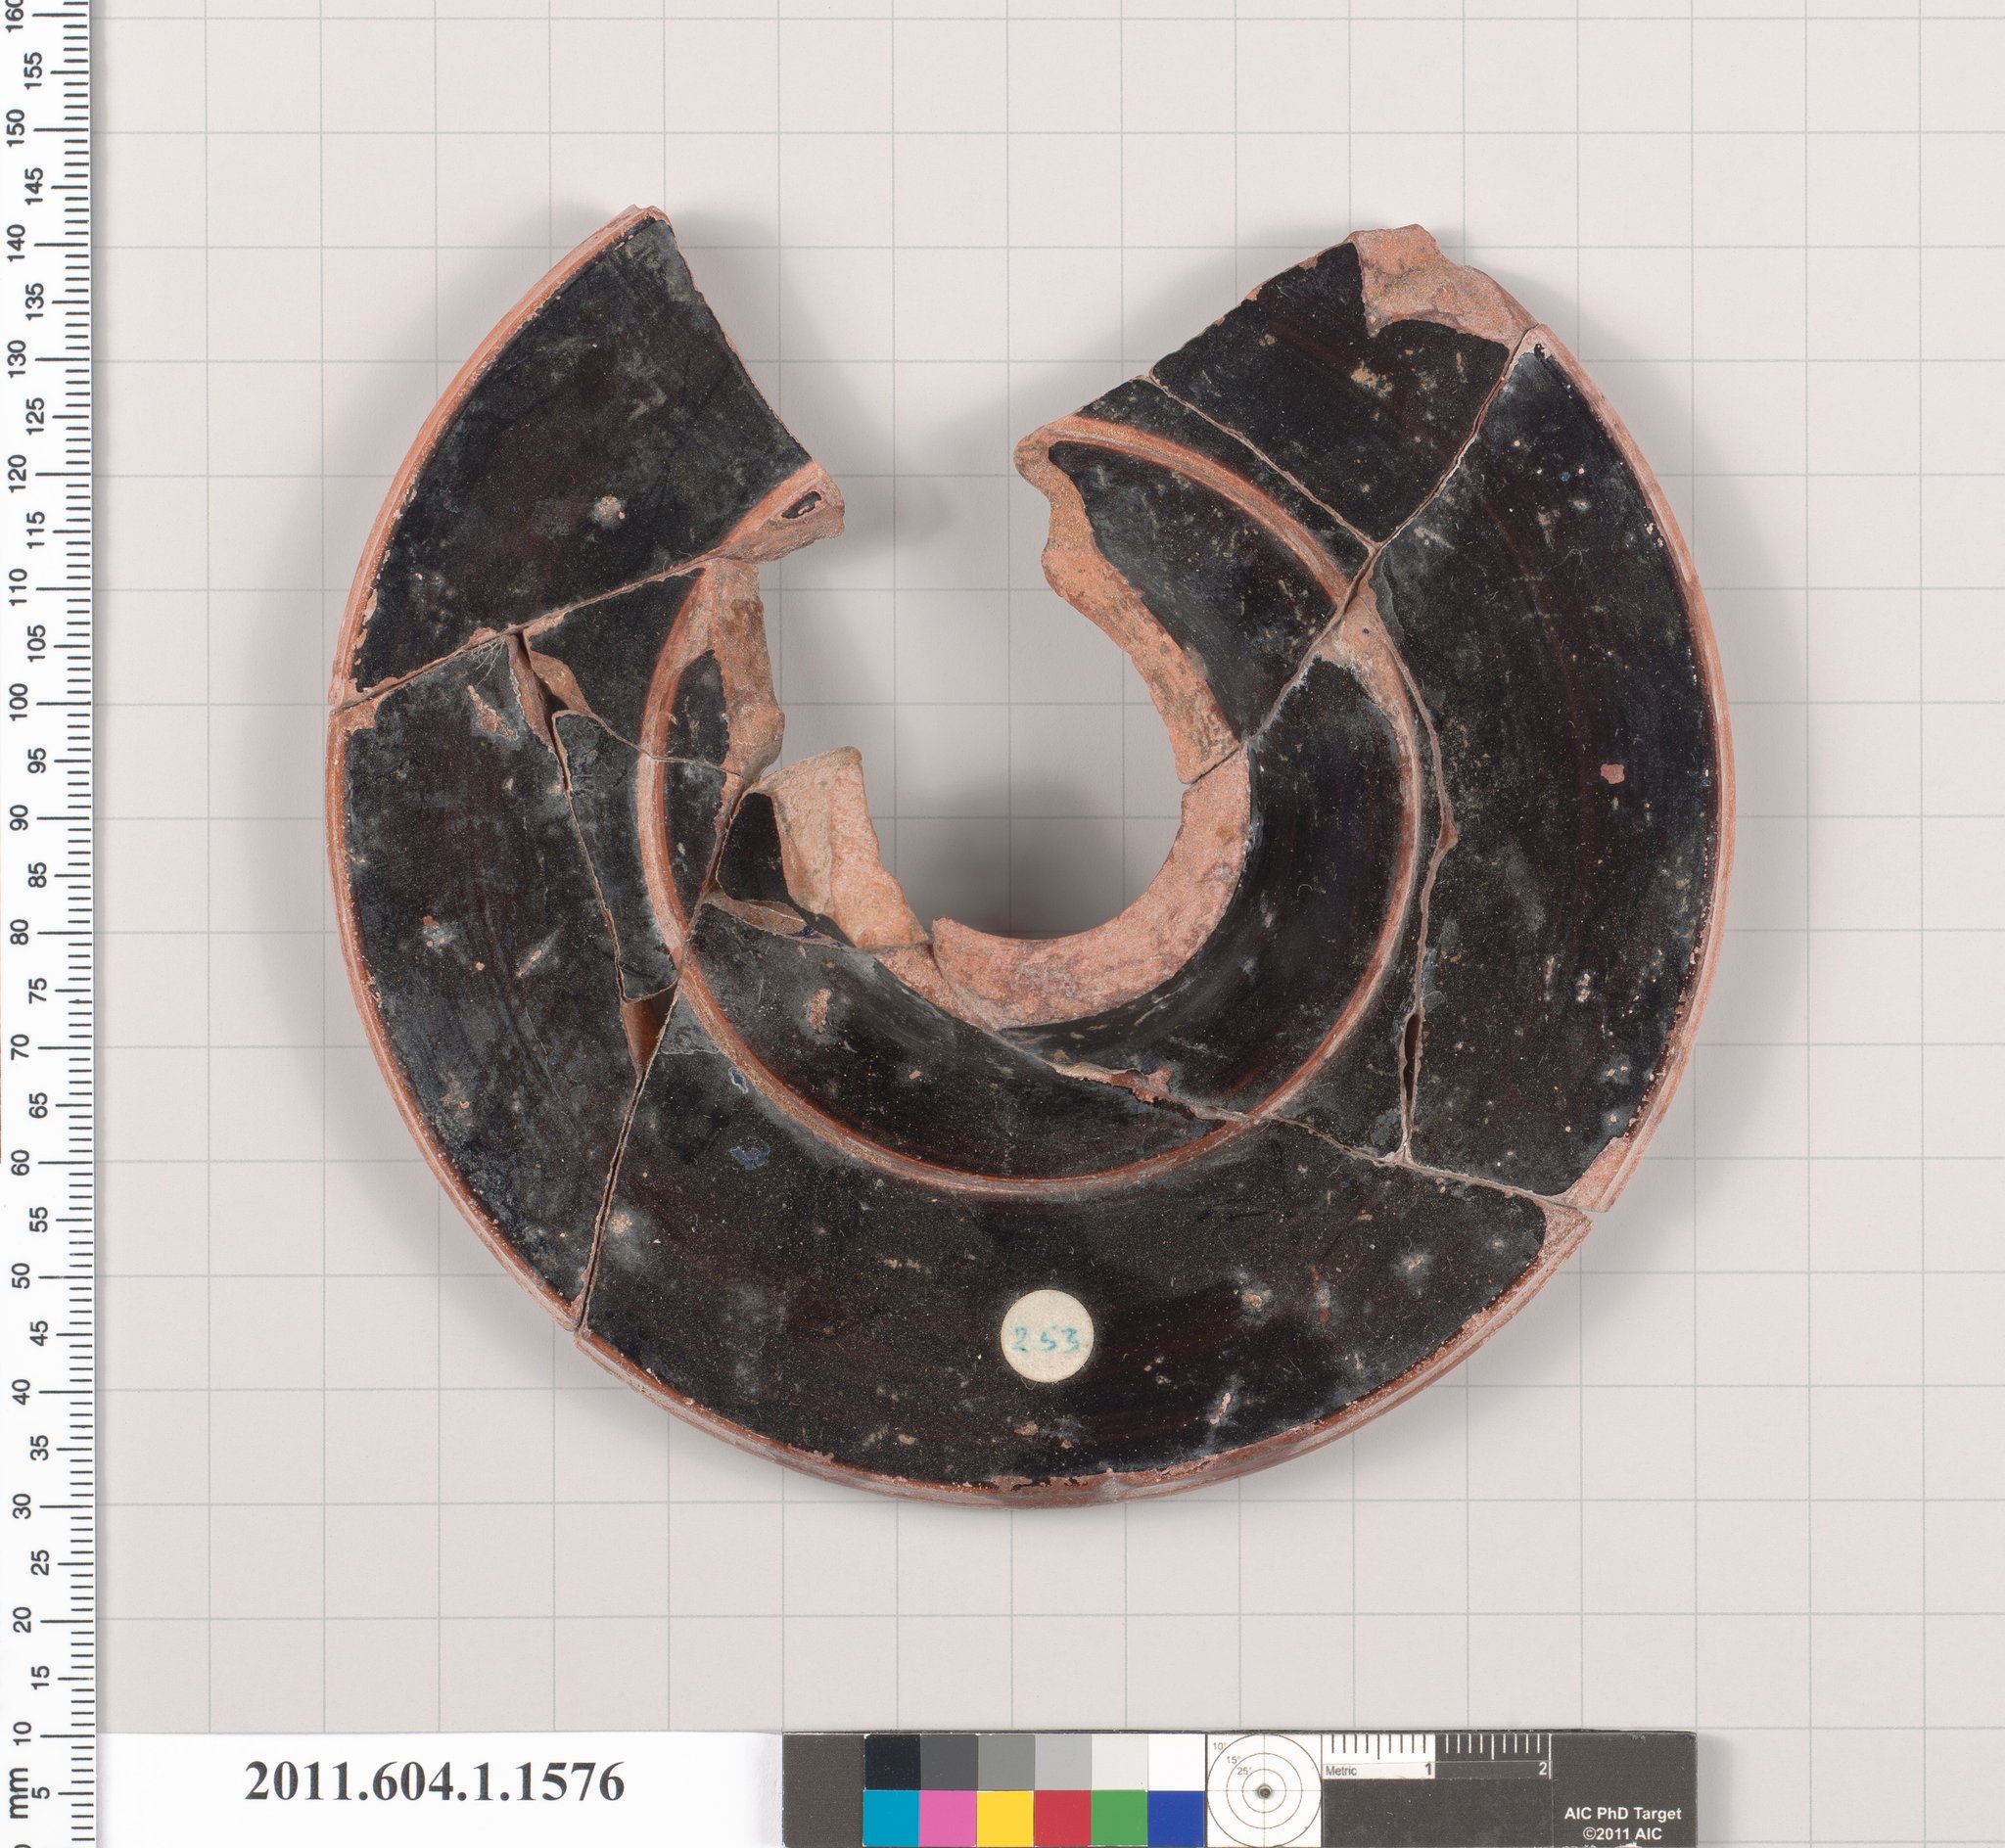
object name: kylix fragment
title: Terracotta fragment of a kylix (drinking cup)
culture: greek, attic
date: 500-401 BCE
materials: terracotta